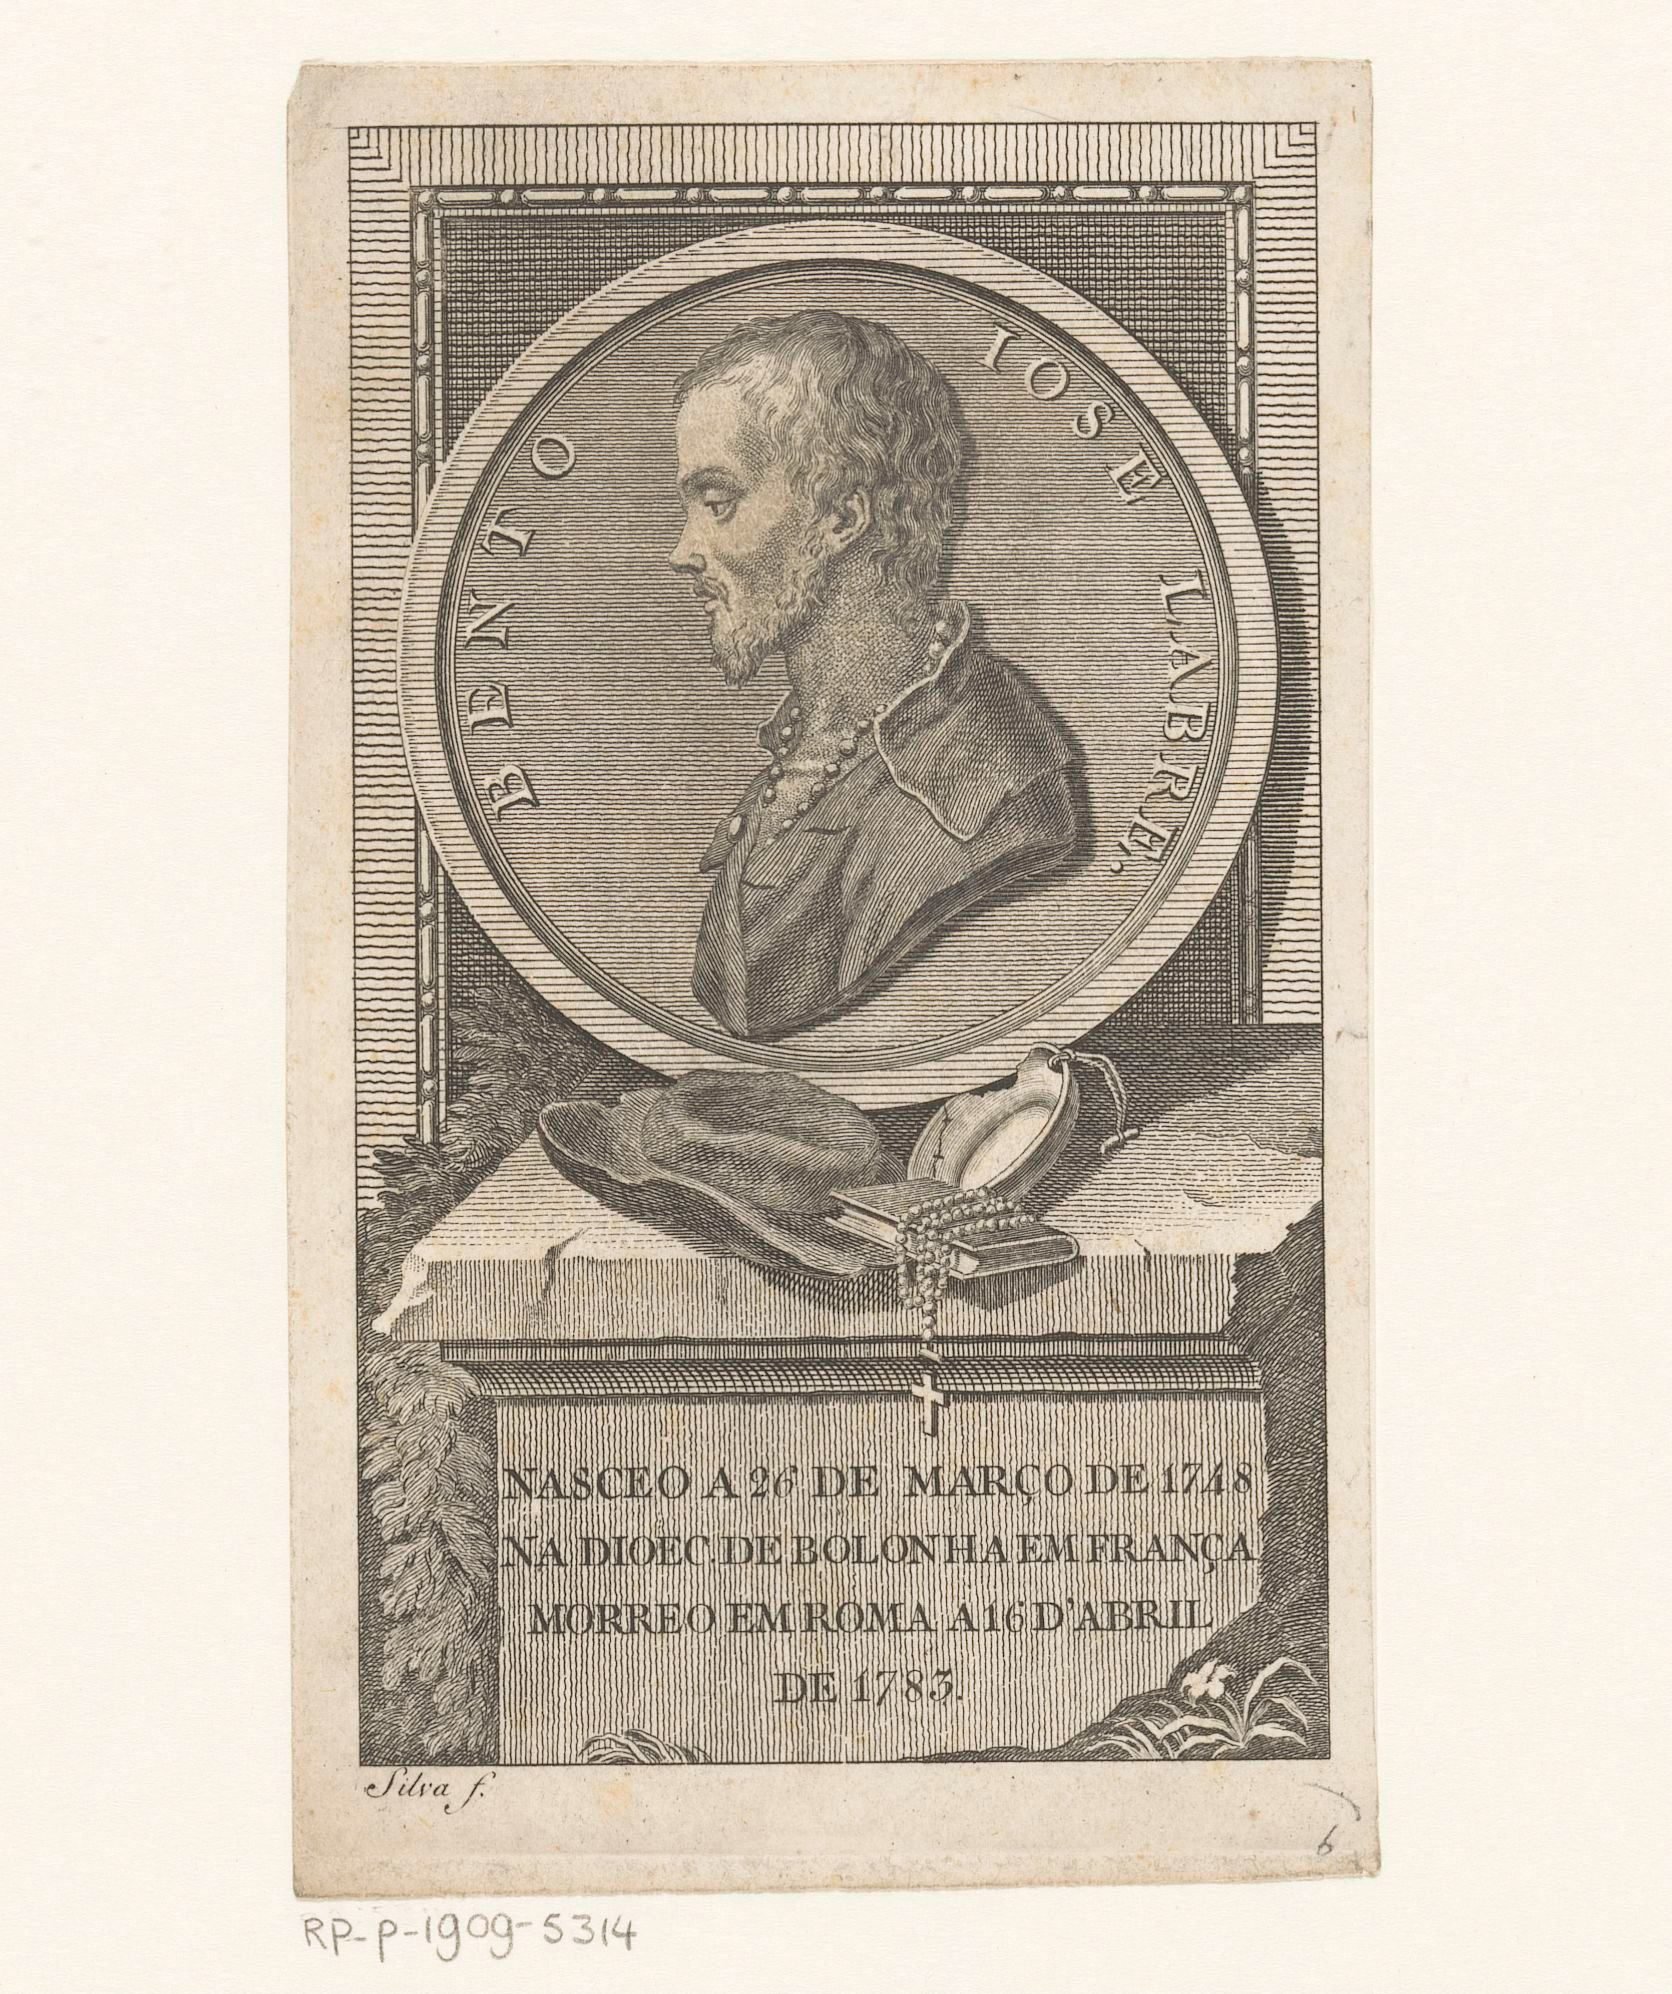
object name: print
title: Portret van de heilige Benedictus Jozef Labre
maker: silva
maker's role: print maker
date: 1786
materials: paper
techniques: etching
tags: rome, historical persons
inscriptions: collector's mark: Lugt 2228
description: Onder het portret een vierregelige Portugese tekst.